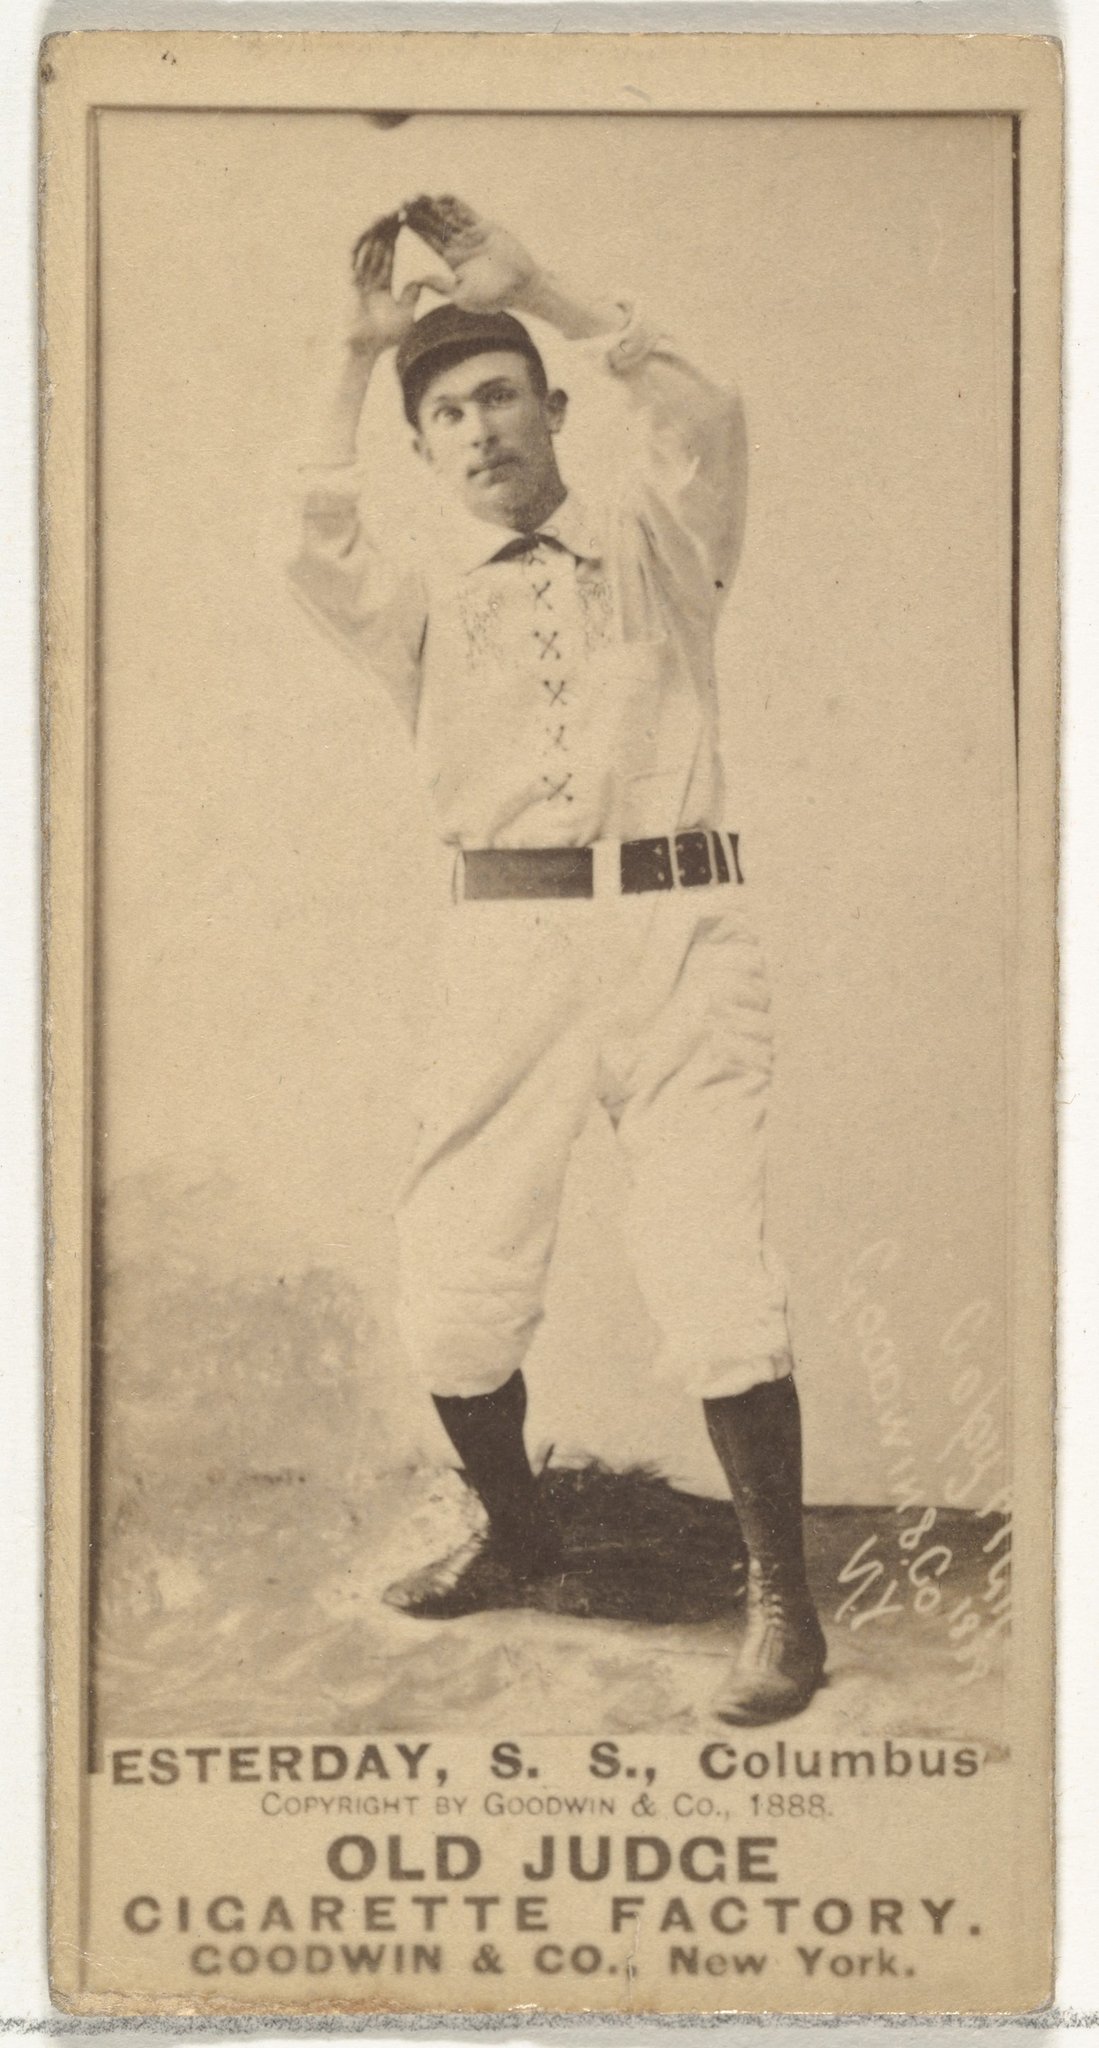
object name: baseball card, photograph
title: Henry P. Easterday, Shortstop, Cleveland, from the Old Judge series (N172) for Old Judge Cigarettes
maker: goodwin & company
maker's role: publisher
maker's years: 1850-1950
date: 1888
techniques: albumen silver print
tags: men,portraits,baseball,athletes